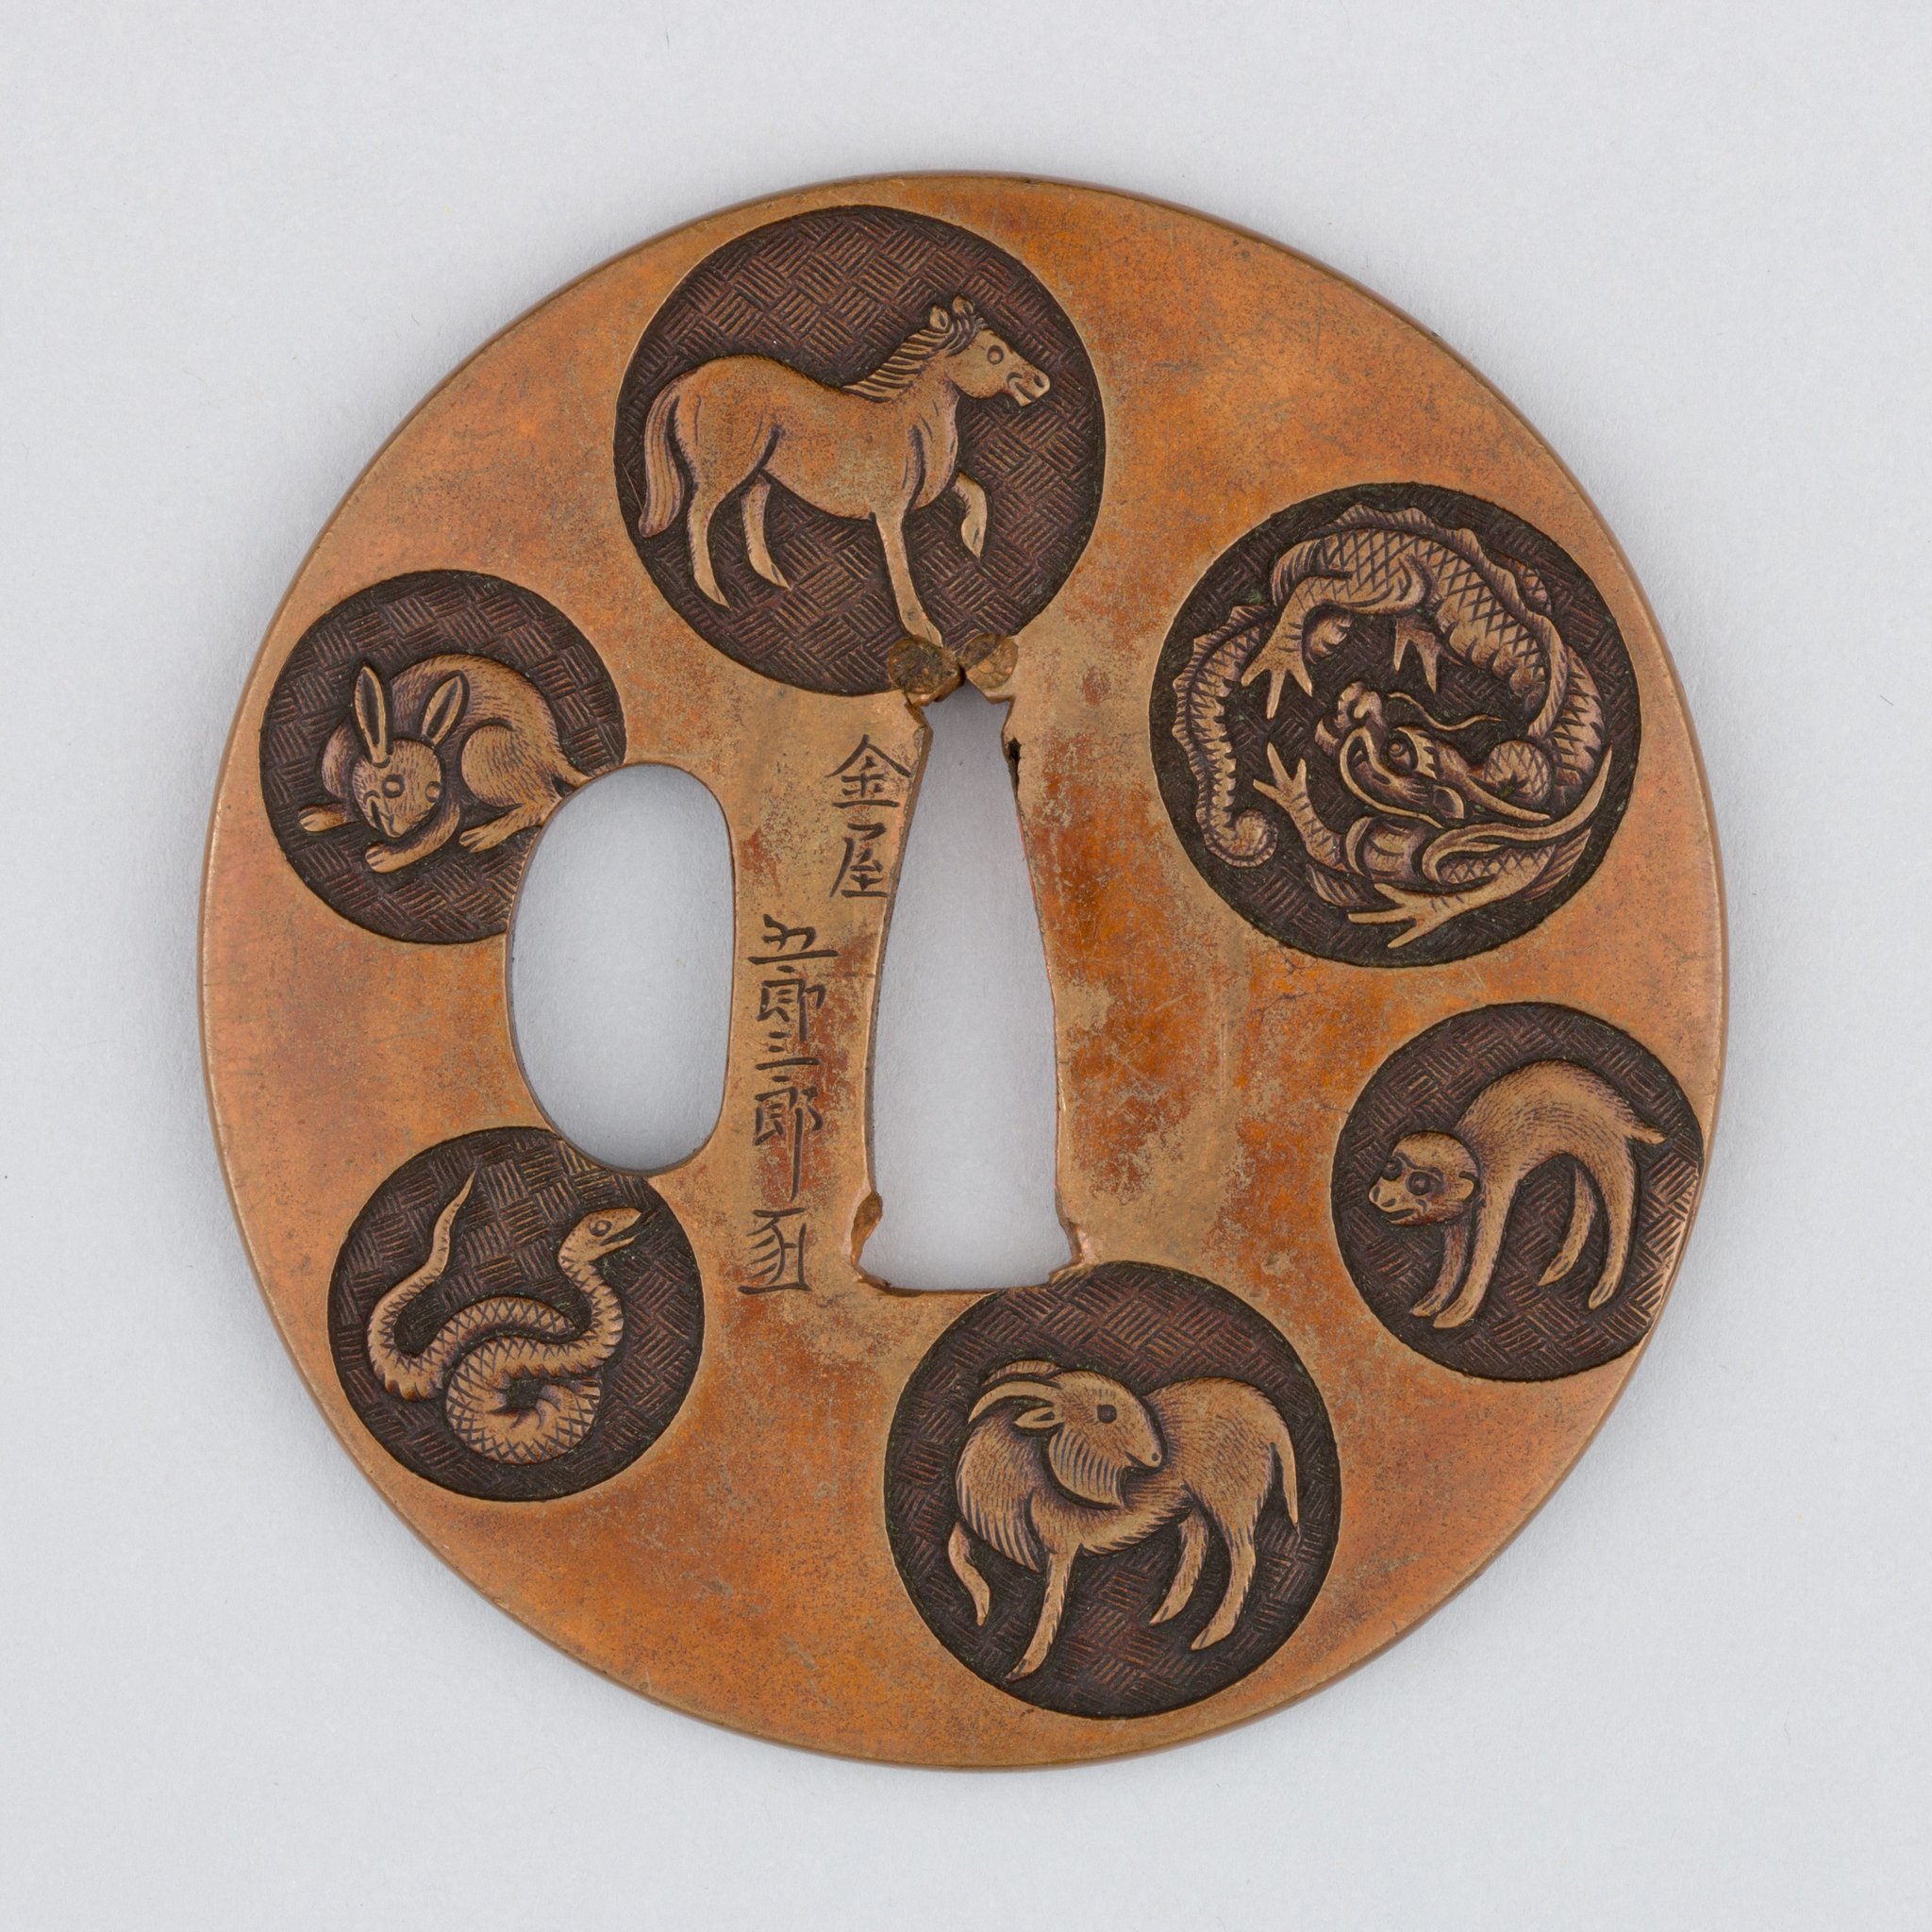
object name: sword guard tsuba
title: Sword Guard (Tsuba)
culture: japanese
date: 1801-1900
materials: copper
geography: japan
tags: dragons,horses,monkeys,rabbits,snakes